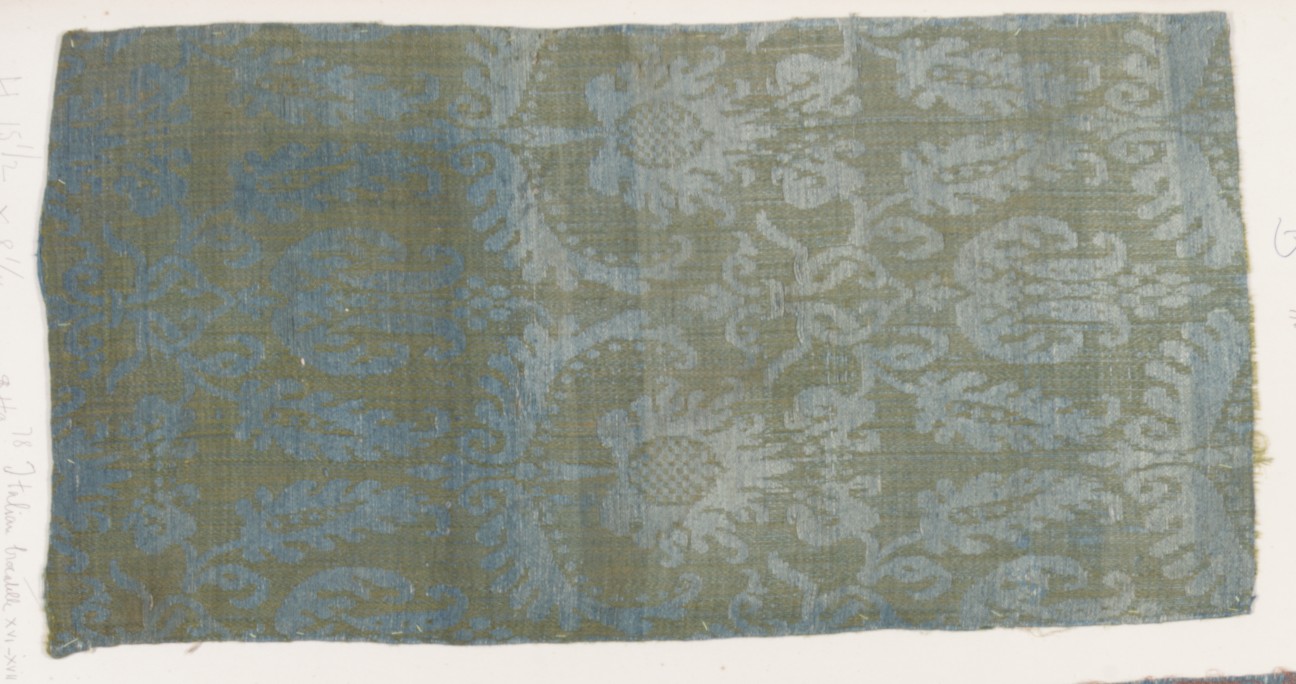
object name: fragment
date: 1501-1700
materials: silk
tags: flowers,leaves